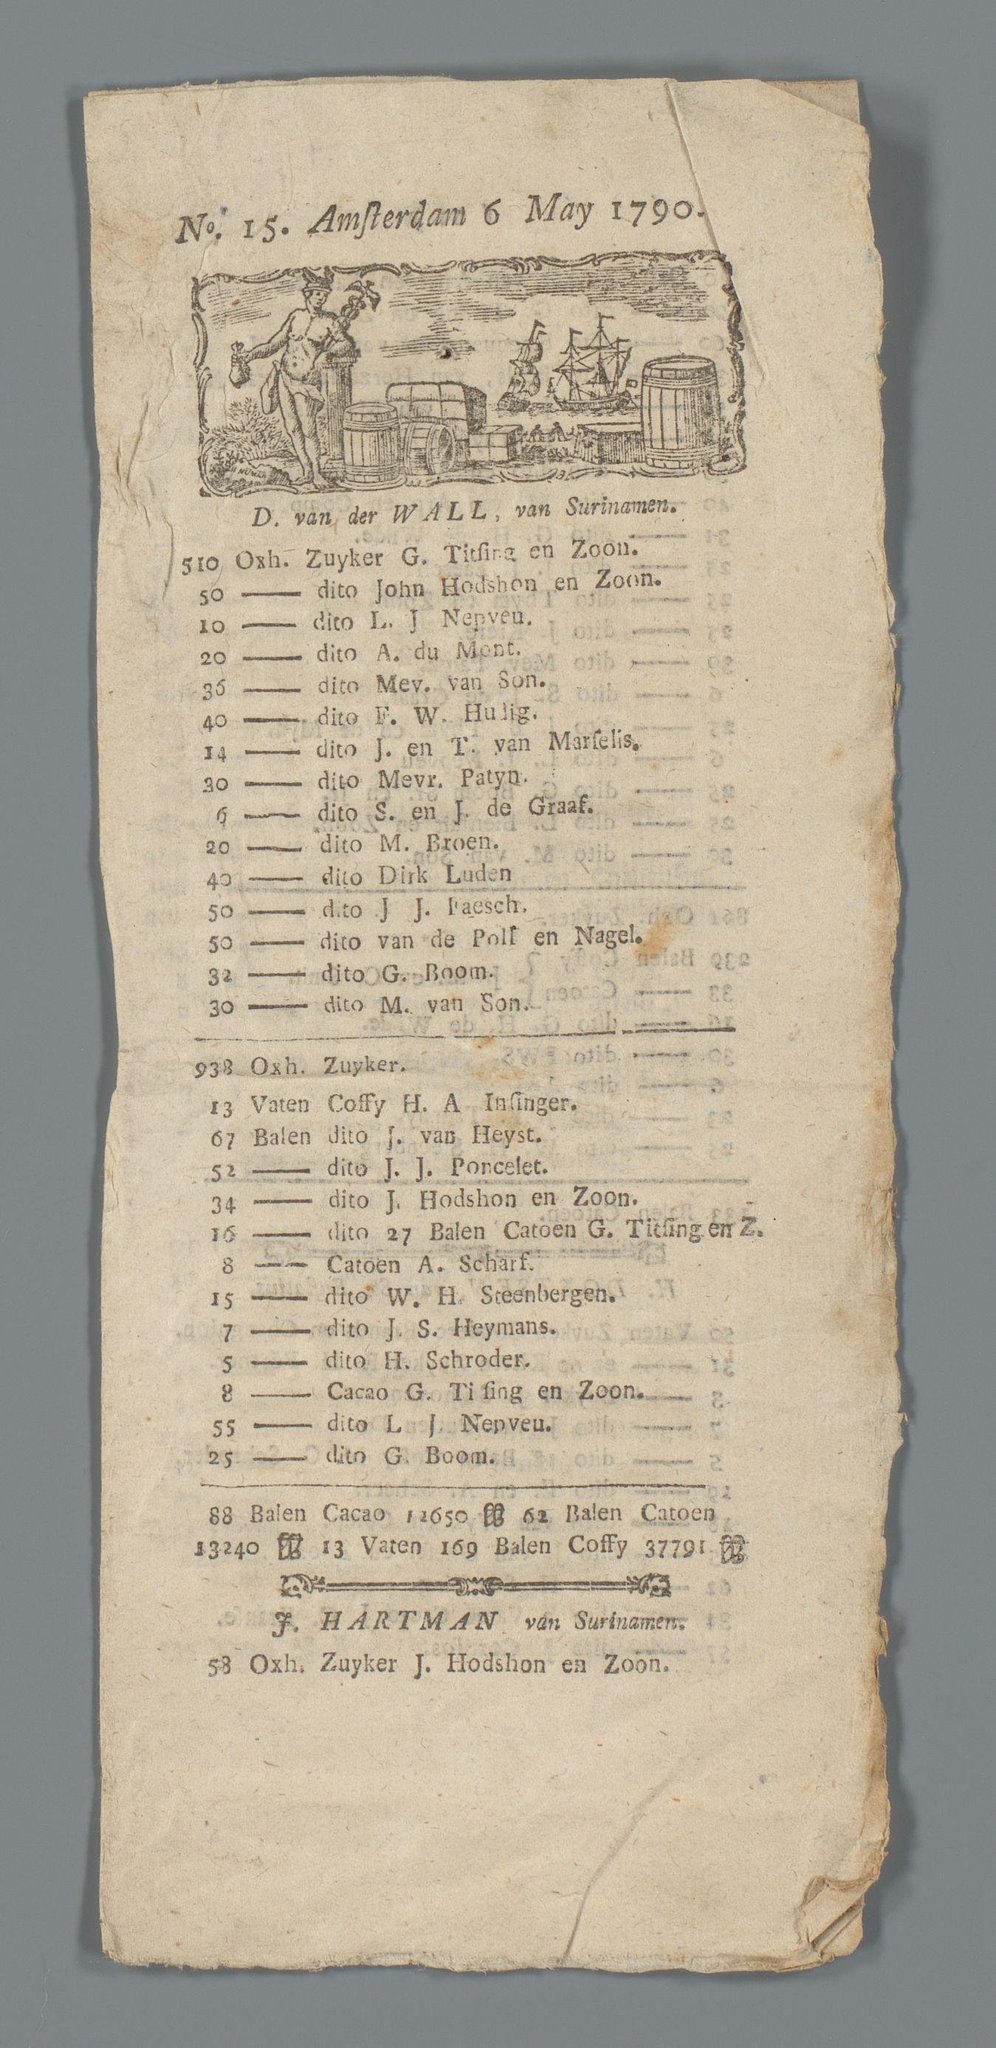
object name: document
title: Scheeps- of beurstijding Nr. 15 Amsterdam 6 Mei 1790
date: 1790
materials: paper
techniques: letterpress printing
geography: amsterdam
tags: specific aspects, allegorical aspects of mercury; mercury as patron, merchant shipping, shipping trade, merchant, salesman, amsterdam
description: Scheeps- of beurstijdingen met lijst van de kapiteins met de plaats waar ze vandaan kwamen en wat ze hebben aangevoerd. In vieren gevouwen blad met tekst, genummerd p. 61-68. Voorzijde bovenaan een vignet met Mercurius op de kade tussen koopwaar, schepen op de achtergrond.